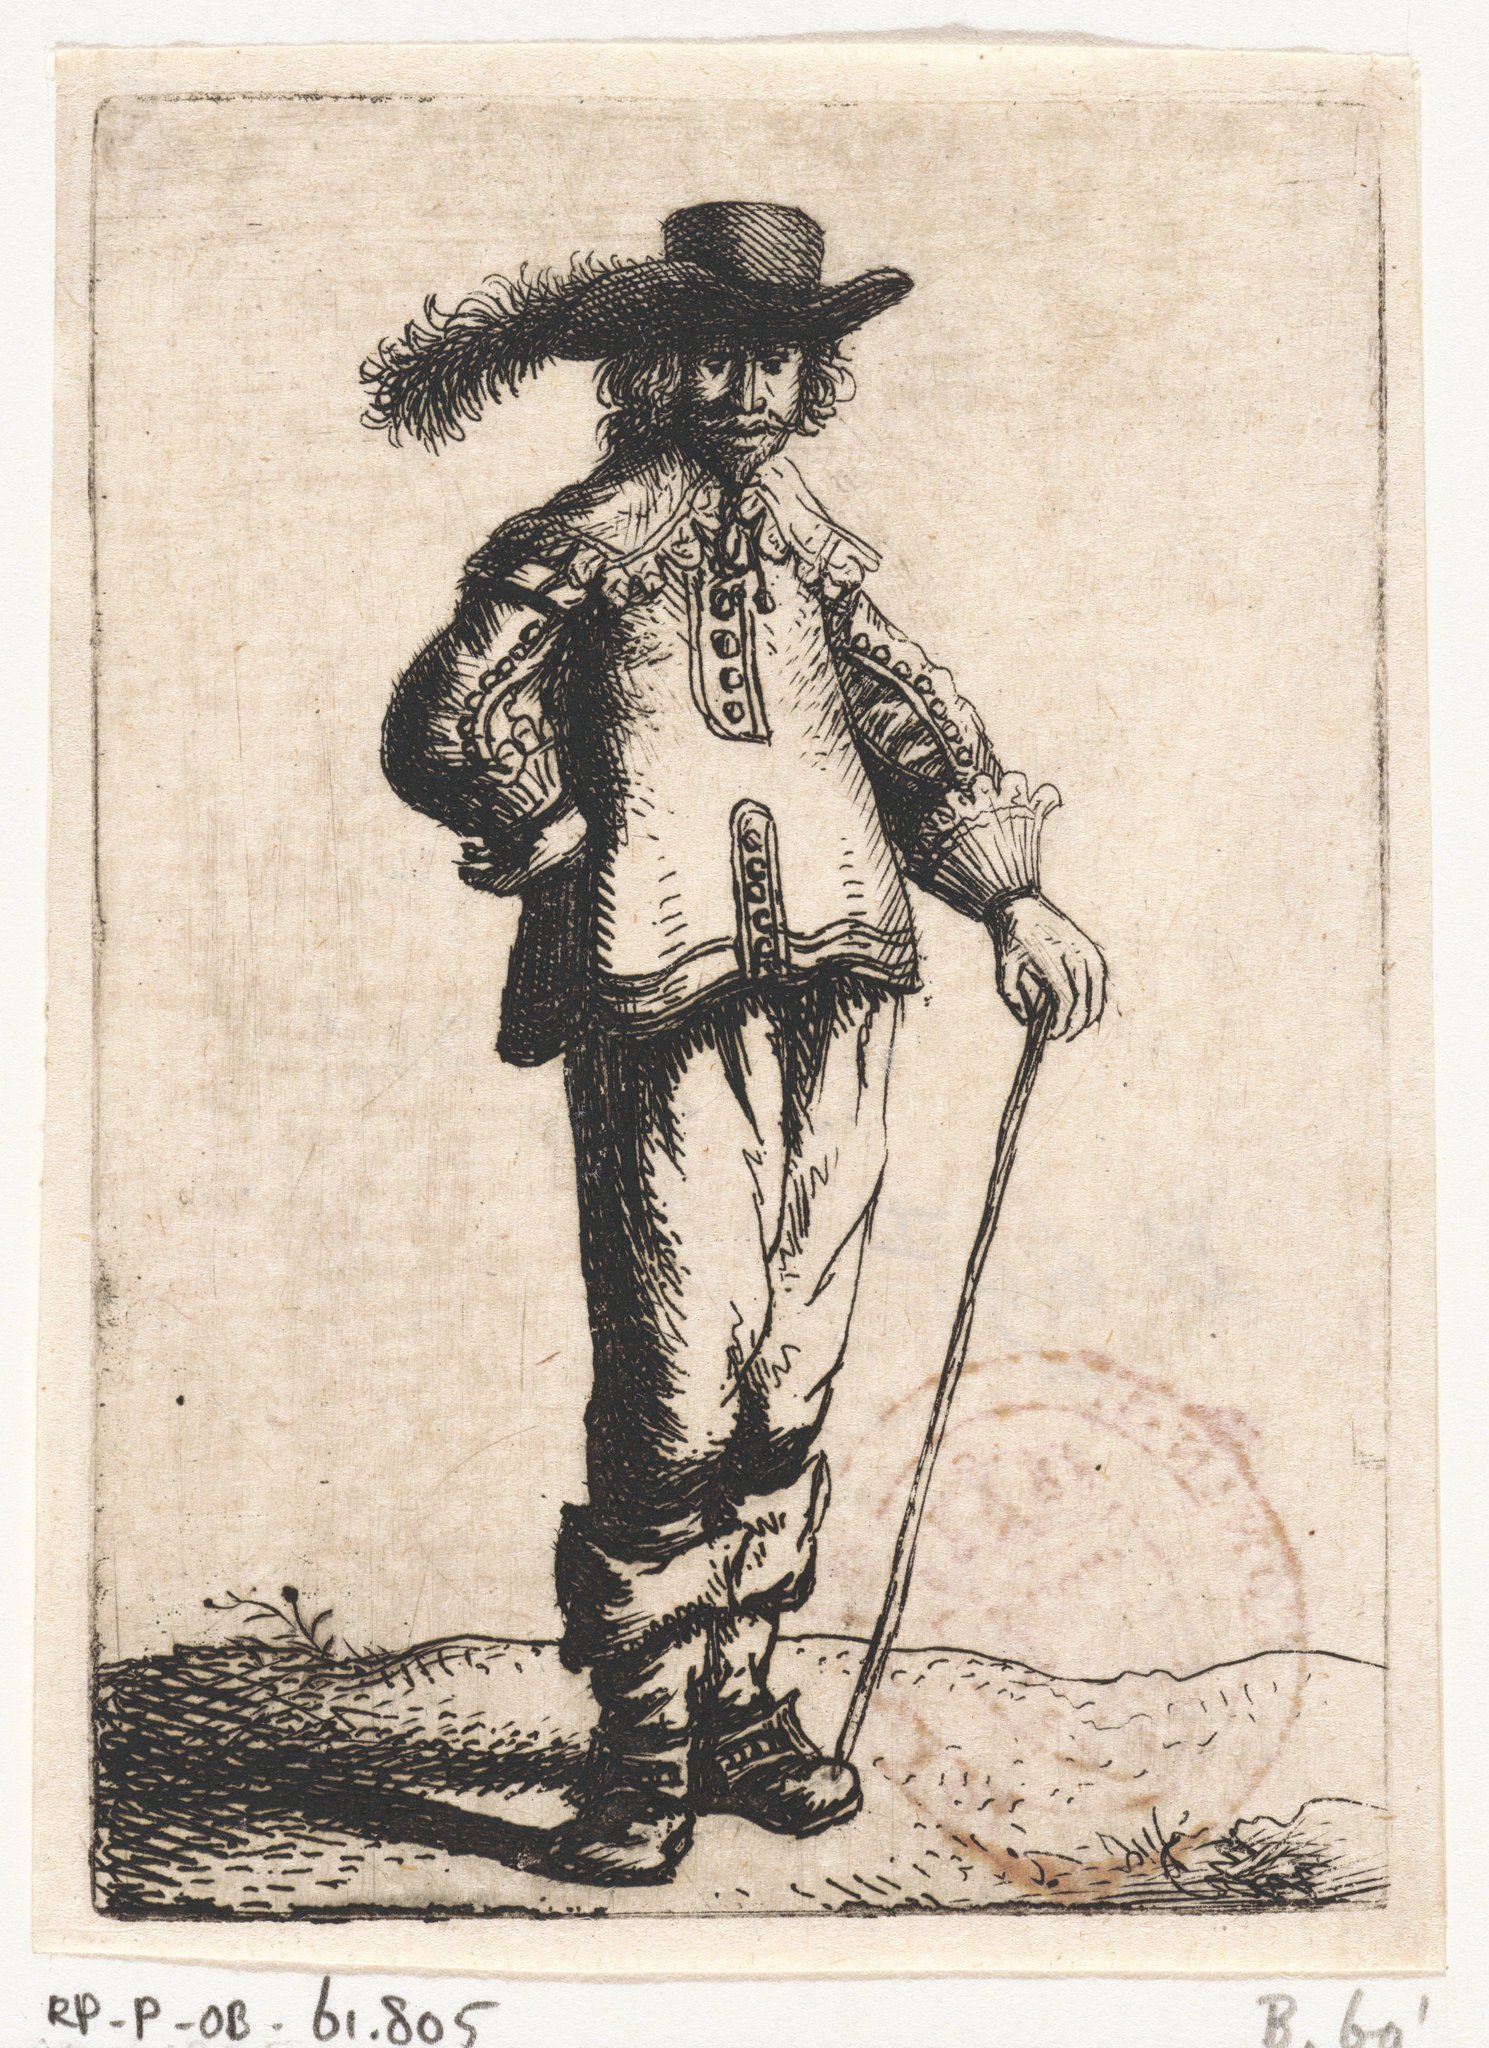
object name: print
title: Staande figuren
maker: jan gillisz. van vliet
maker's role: draughtsman, painter, print maker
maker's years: 1600-1668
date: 1635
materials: paper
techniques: engraving, etching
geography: leiden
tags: hand on the hip (+ front view), walking-stick, staff, head-gear: hat (+ feathers used for clothes)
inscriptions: collector's mark: Lugt 240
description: Een elegant geklede man met een wandelstok en een hoed met een veer, met zijn hand in zijn zij.